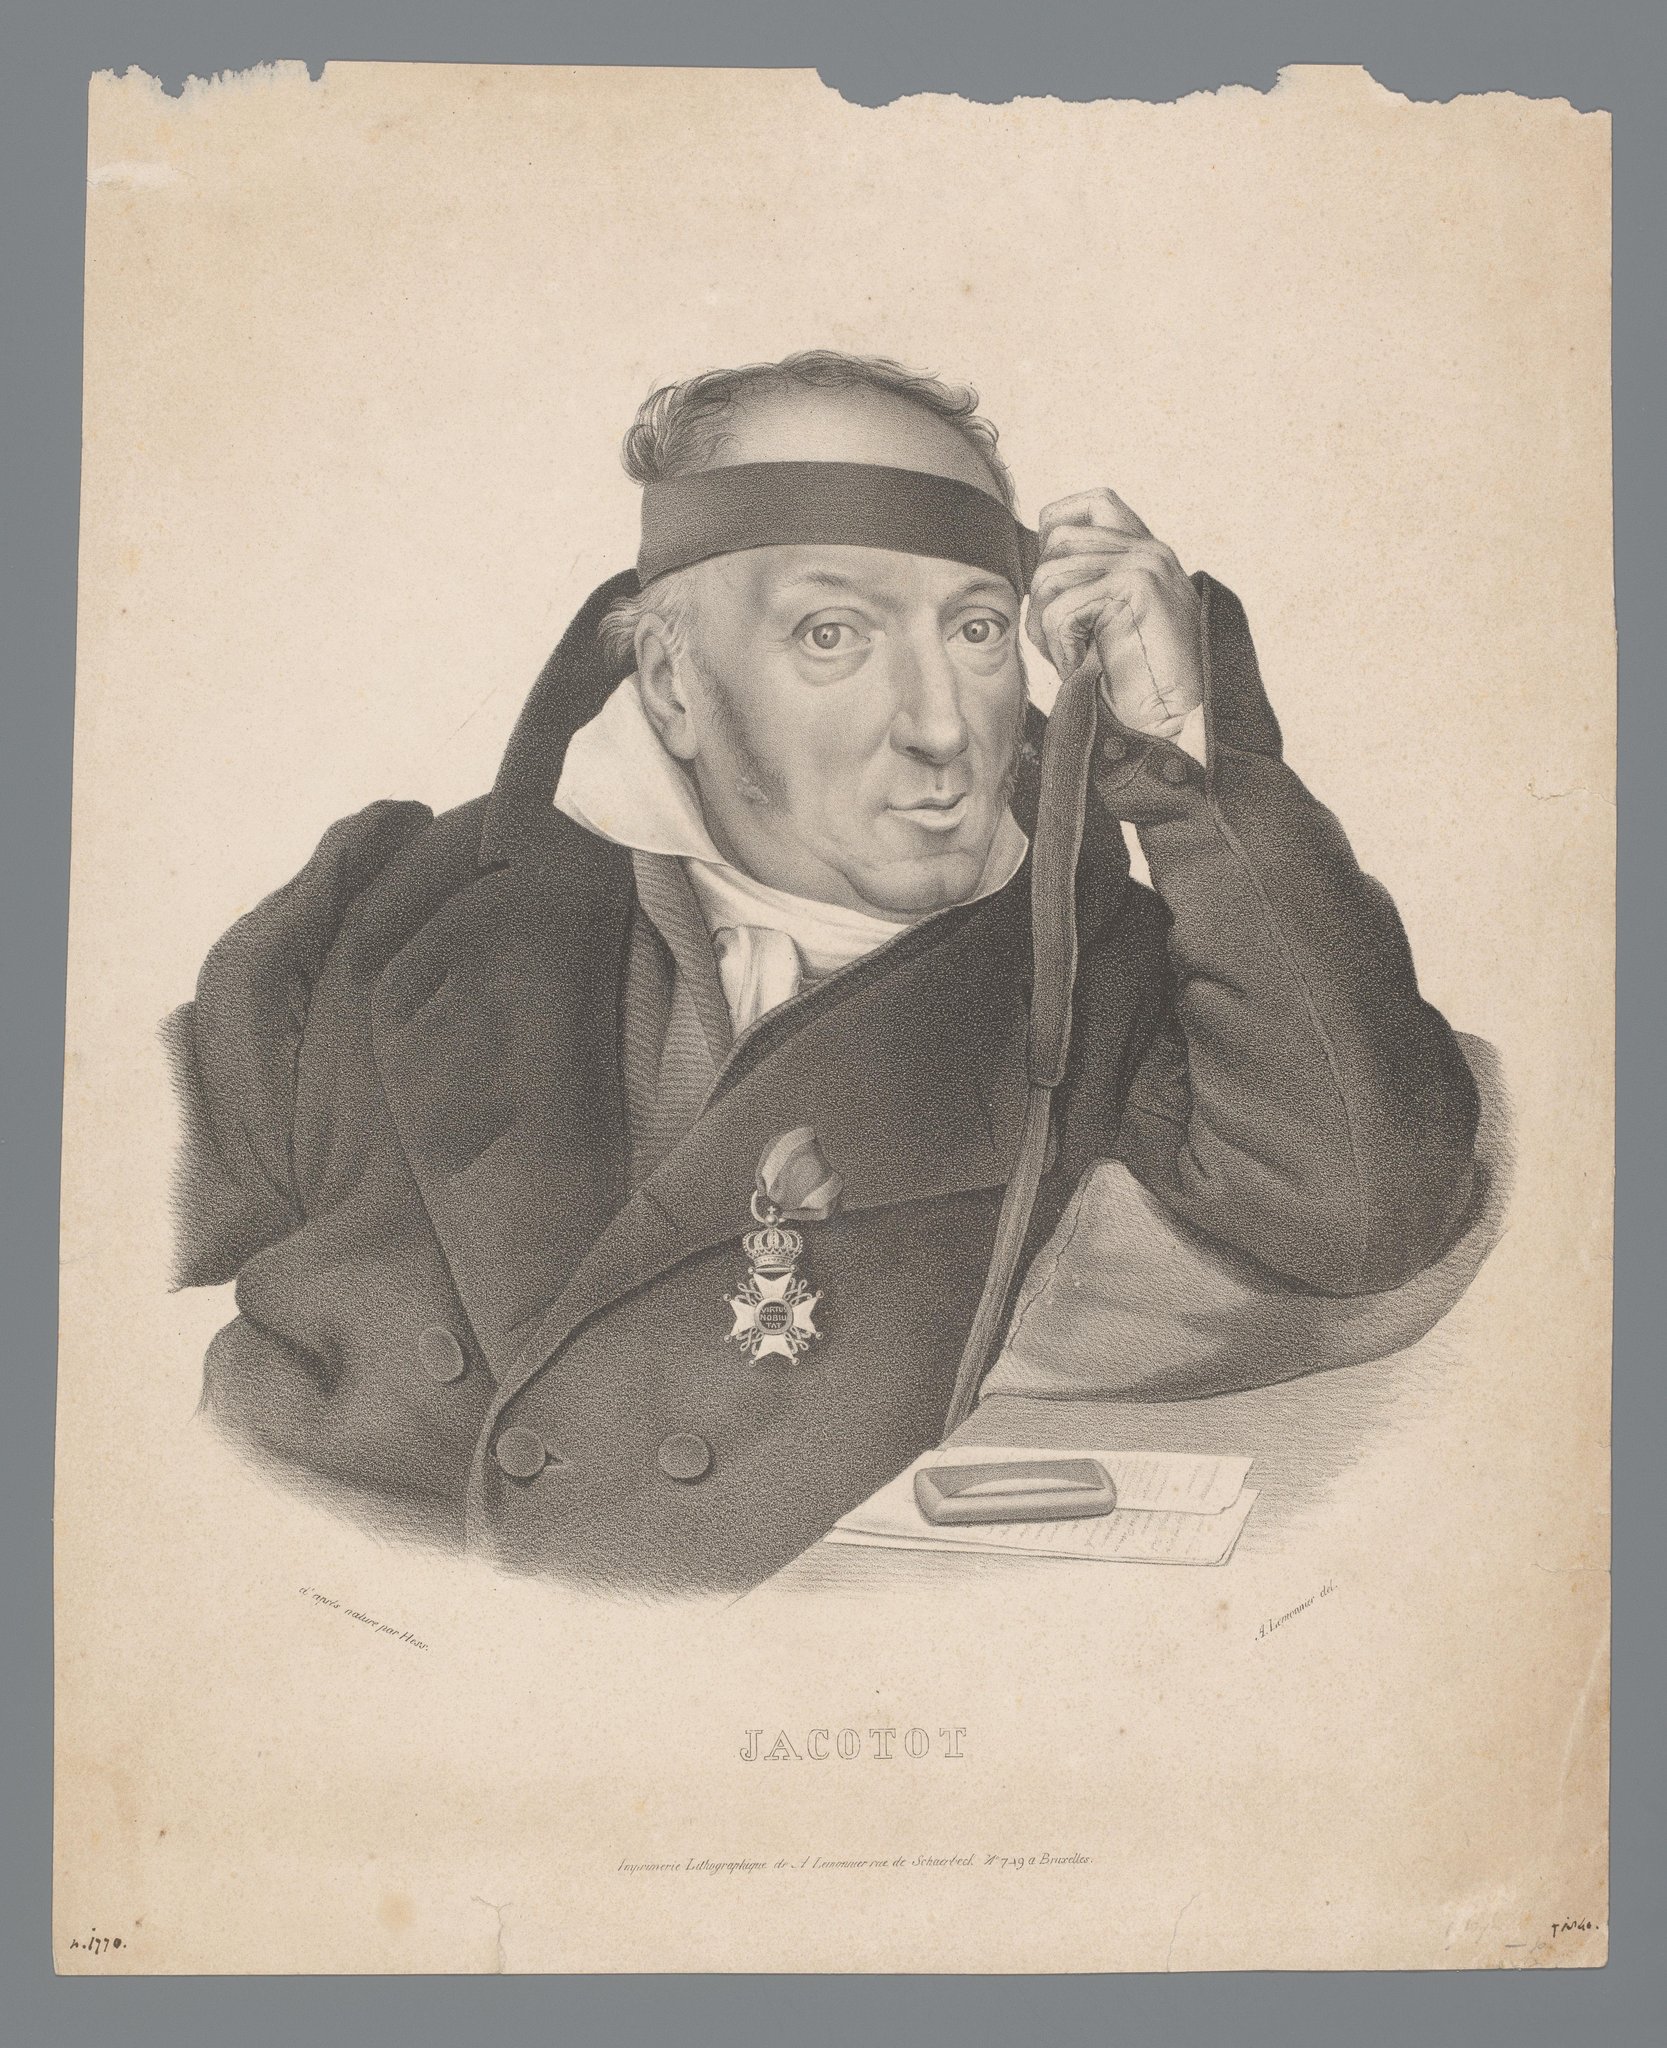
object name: print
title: Jacotot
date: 1829-1833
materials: paper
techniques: lithograph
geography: brussels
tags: paris, adult man, historical persons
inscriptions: collector's mark: Lugt 2228